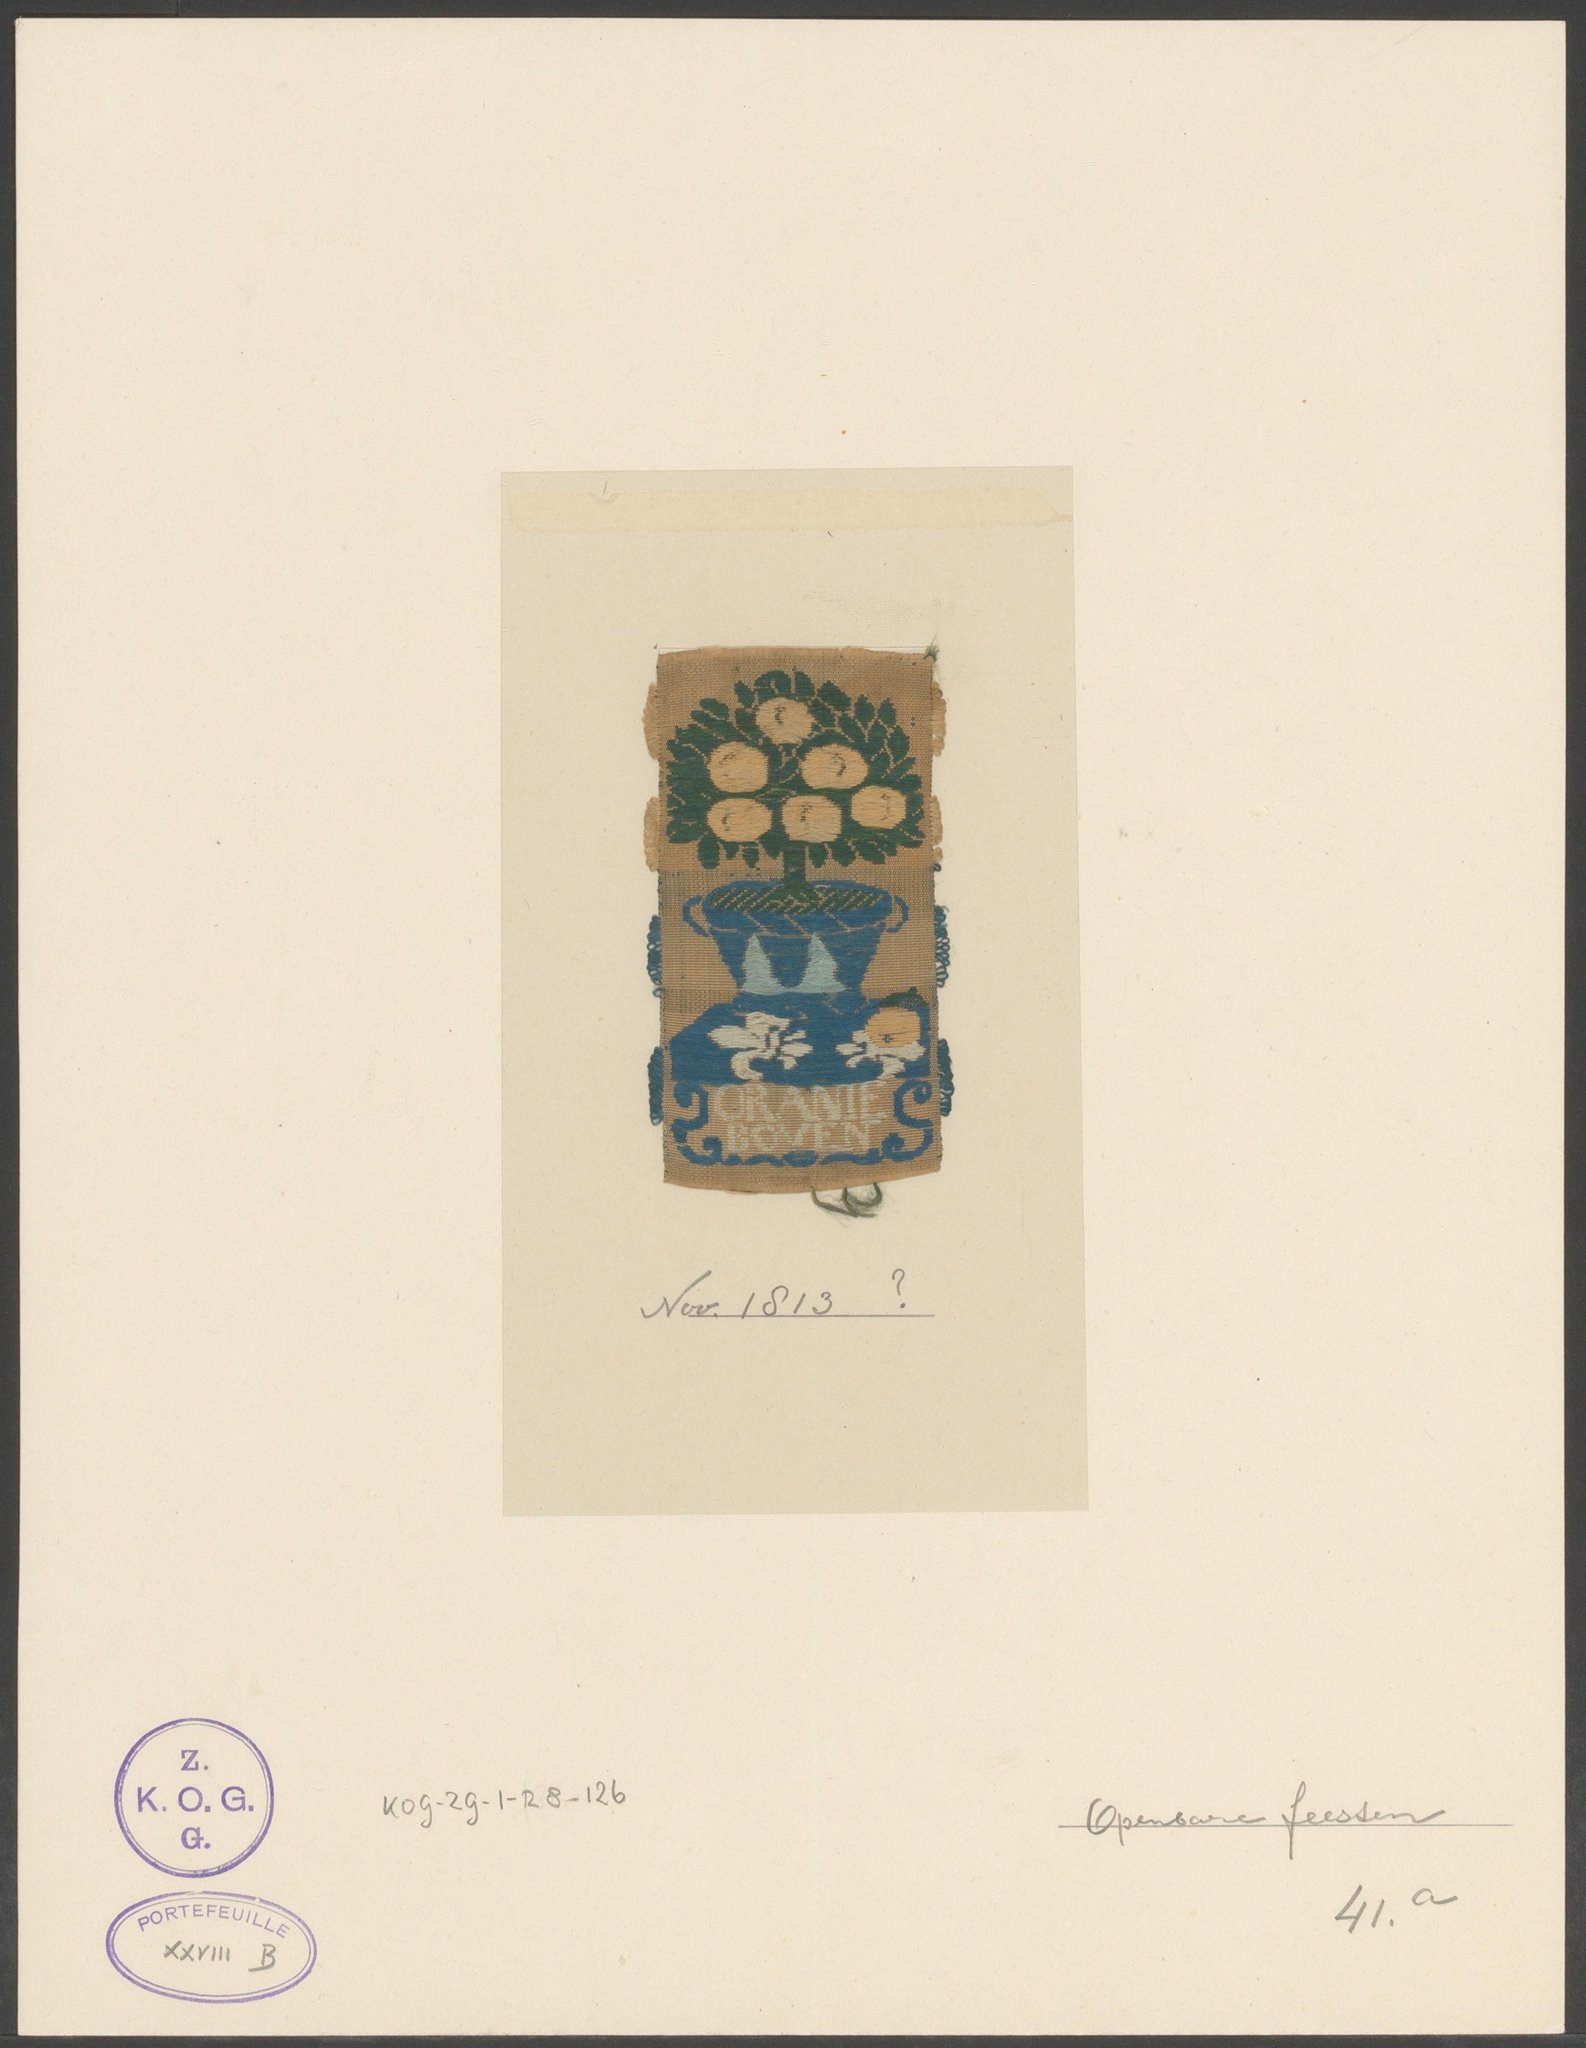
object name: ribbon material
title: Lint met oranjeboom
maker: Anonymous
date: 1811-1813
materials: textile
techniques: embroidered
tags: slag bij waterloo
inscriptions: stamp, collector's mark: Lugt 1641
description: Onderwerpsrubrieken binnen de Atlas Zeden en Gewoonten: Zeden en Gewoonten in Engeren Zin. Volksleven. Openbare feesten. Vorstelijke intochten, (Illuminaties, vuurwerken en dergelijke, openbare feesten).